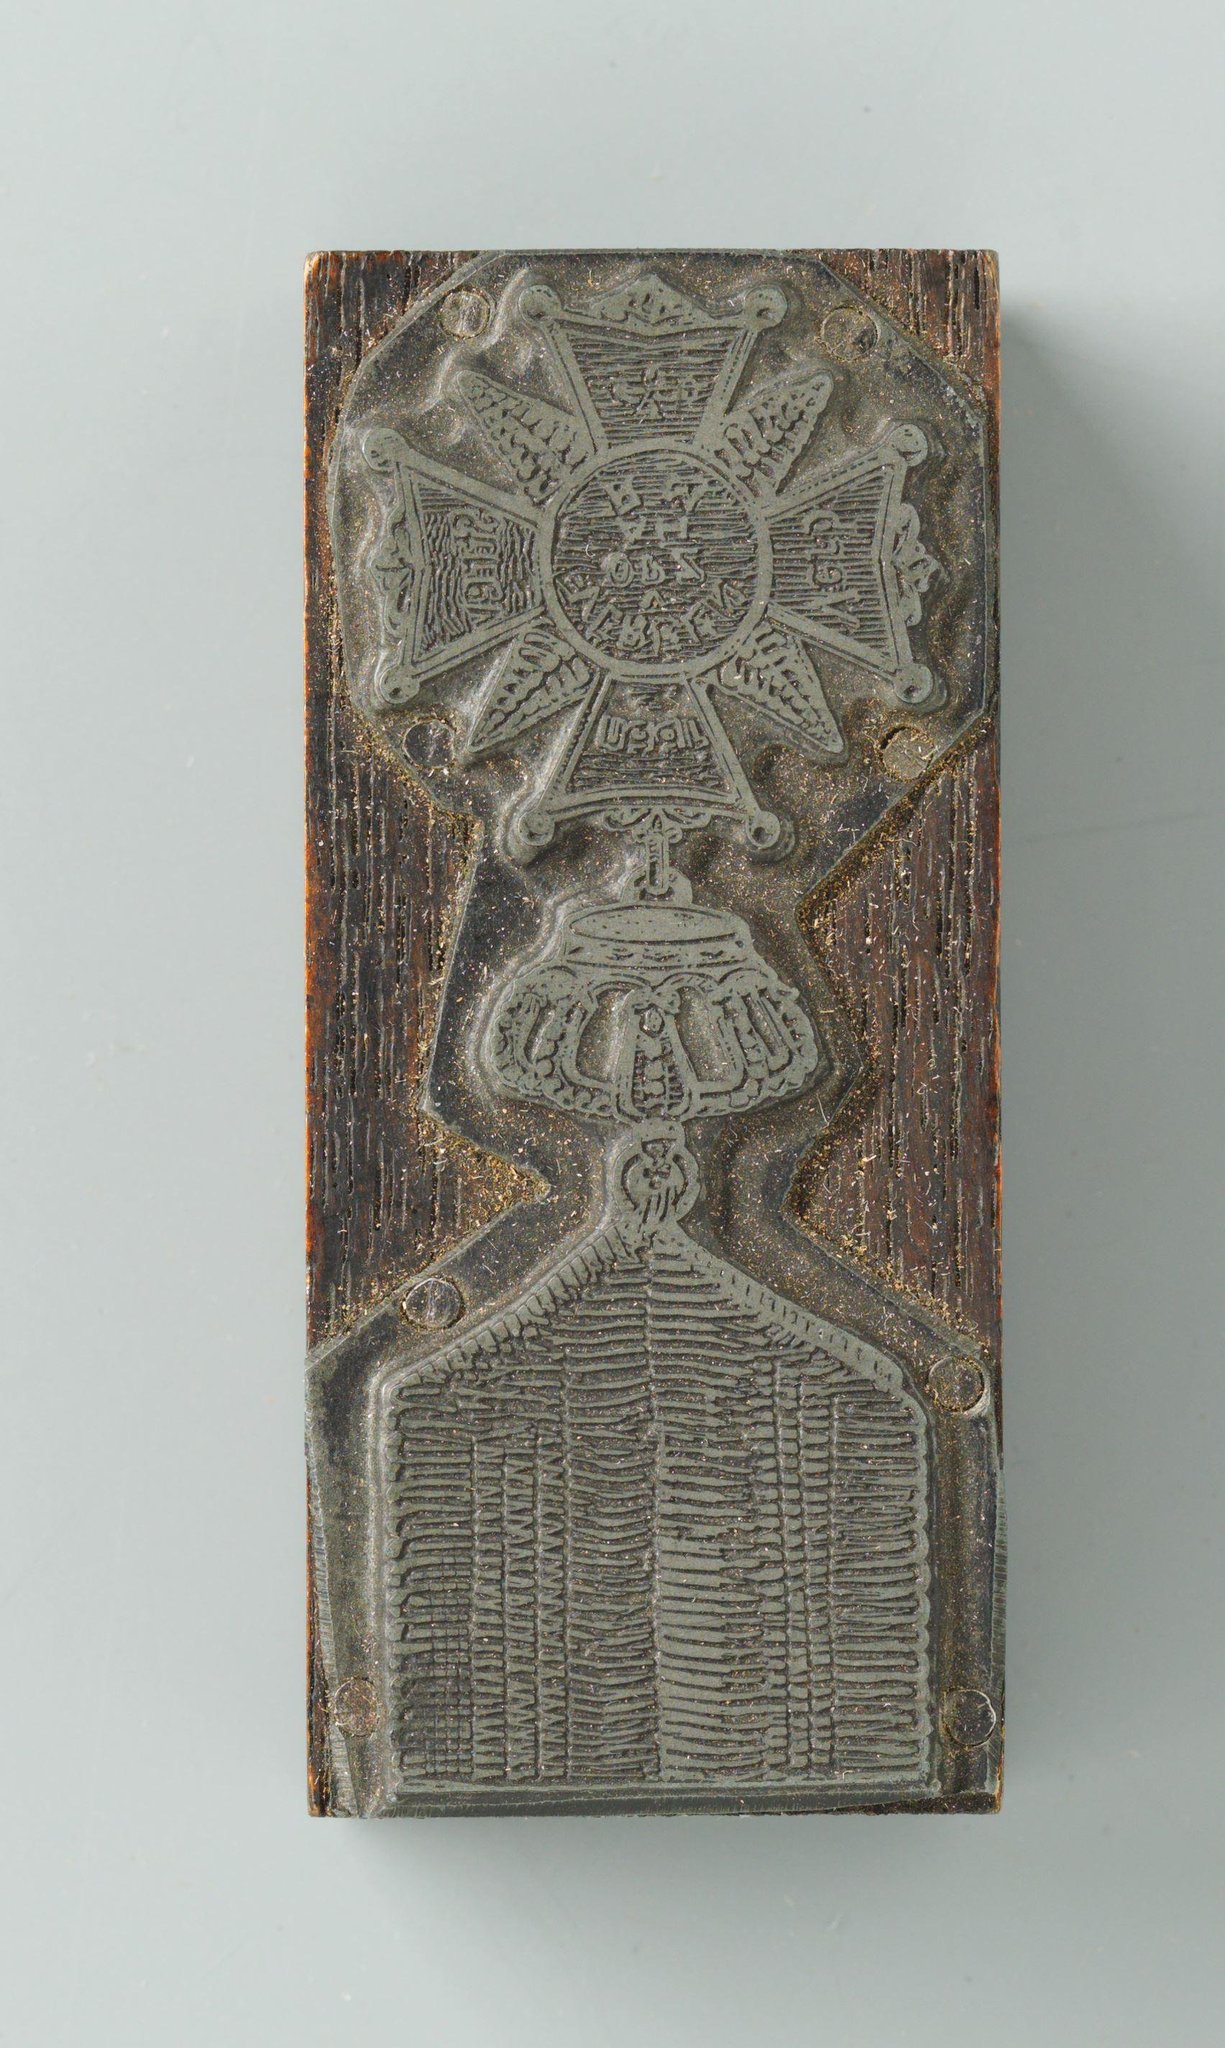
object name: zinkplaat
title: Ridderorde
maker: Anonymous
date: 1870-1930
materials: wood, zinc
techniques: printing block